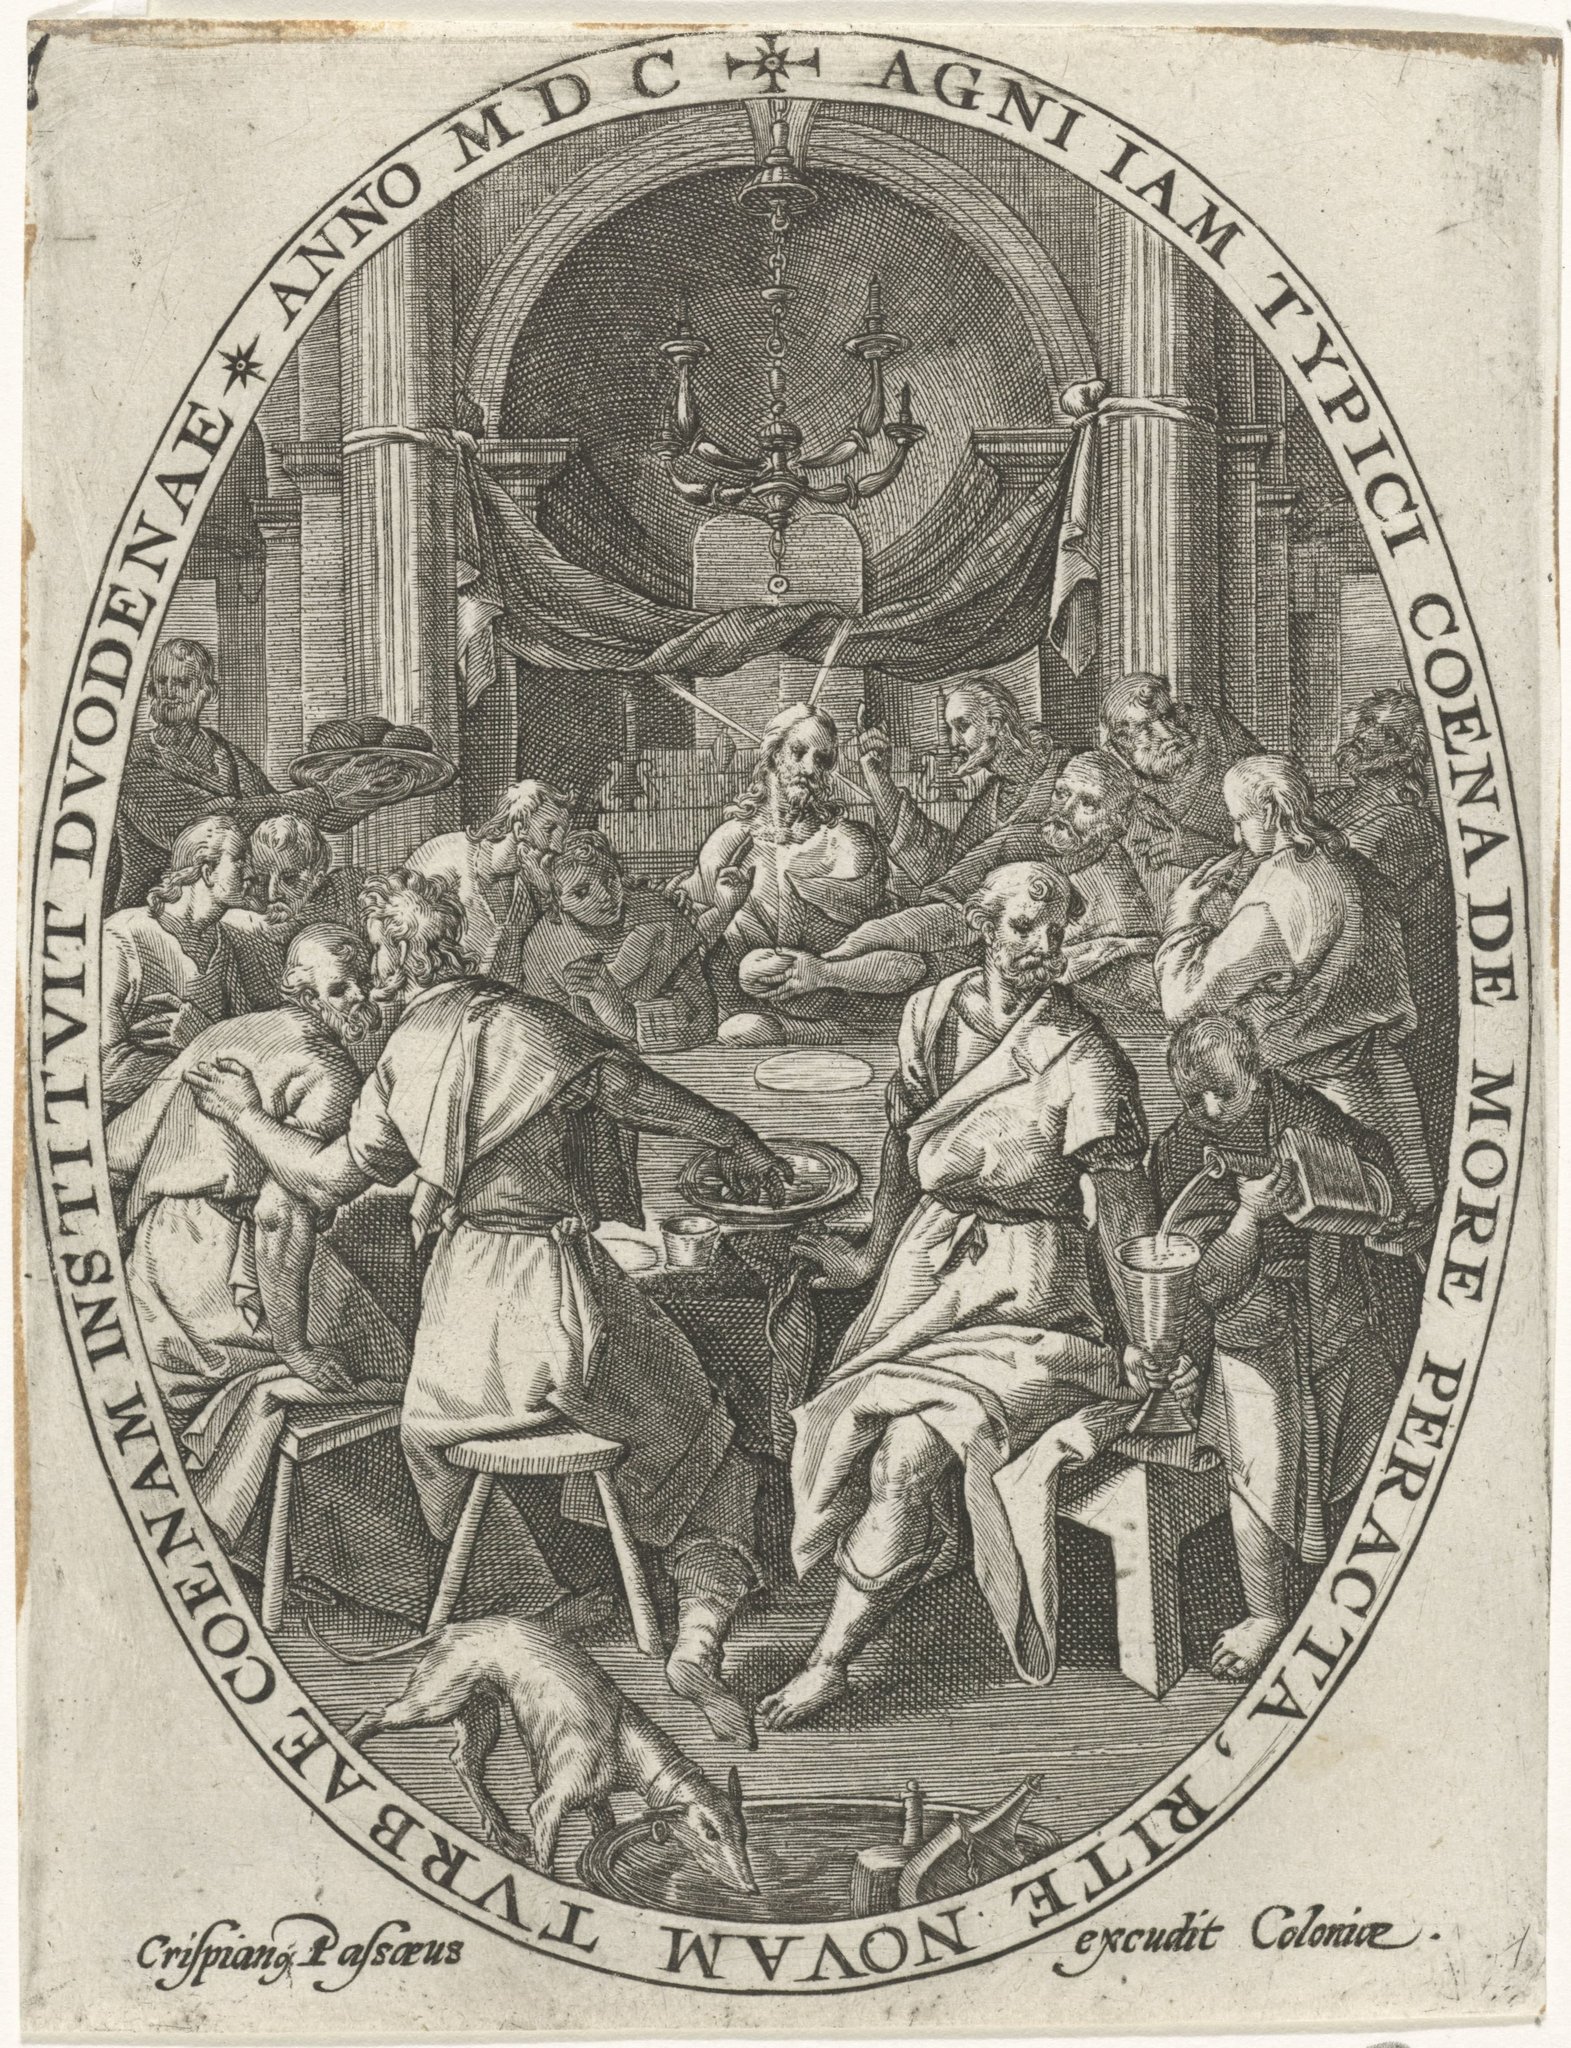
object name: print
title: Laatste Avondmaal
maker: crispijn van de passe (i)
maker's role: draughtsman, print maker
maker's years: 1564-1637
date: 1600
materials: paper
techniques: engraving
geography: cologne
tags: institution of the eucharist, i.e. christ showing or blessing bread (host) and/or wine (matthew 26:26-27; mark 14:22-23; luke 22:19-20; john 13:26; 1 corinthians 11:23-25), last supper (in general) (matthew 26:21-35; mark 14:18-31; luke 22:3, 22:15-23; john 13:21-38)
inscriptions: collector's mark: Lugt 2542, collector's mark: Lugt 2228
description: Christus en zijn leerlingen zitten rond een tafel. Christus houdt het brood vast en maakt een zegenend gebaar. Op de achtergrond op een altaar staan de tafelen der wet. De voorstelling is gevat in een ovale omlijsting met een randschrift in het Latijn. Prent uit een serie met de passie van Christus.